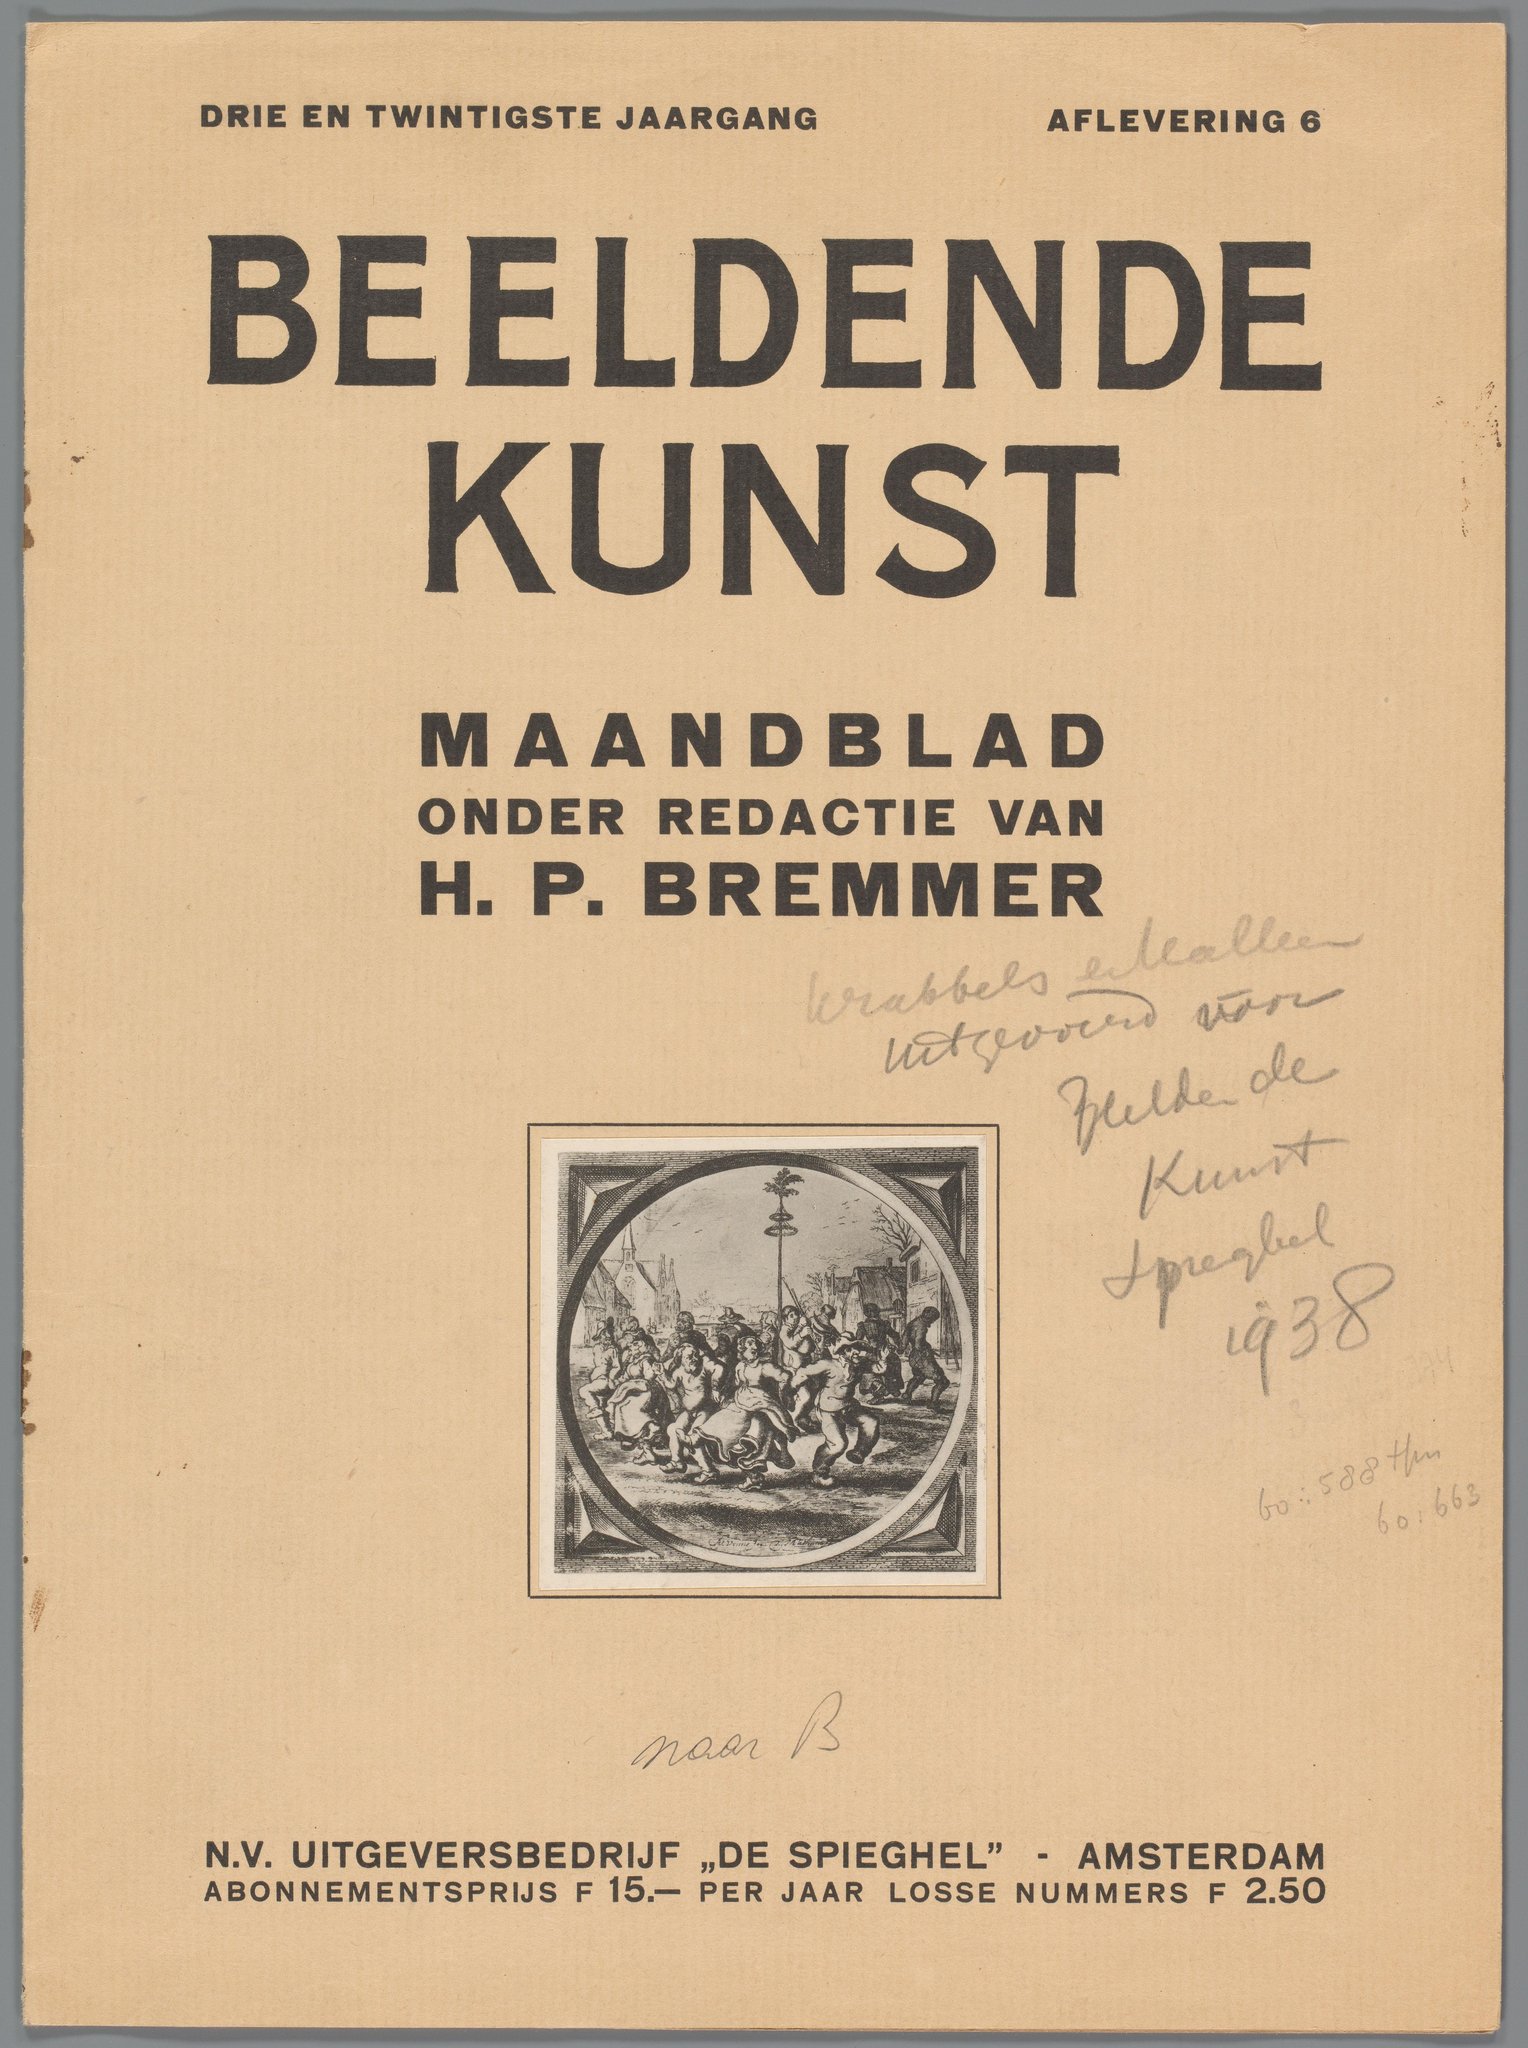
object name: print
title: Maandblad Beeldende Kunst, 1936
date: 1936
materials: paper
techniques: letterpress printing, photochemical processes, snipping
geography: amsterdam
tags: weekly, monthly, magazine, etc.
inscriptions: inscription: ‘krabbels en e[...]alleen / uitgevoerd voor / Beeldende / Kunst / Spieghel / 1938’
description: Maandblad van de Beeldende Kunst, 23ste Jaargang, Aflevering 6.